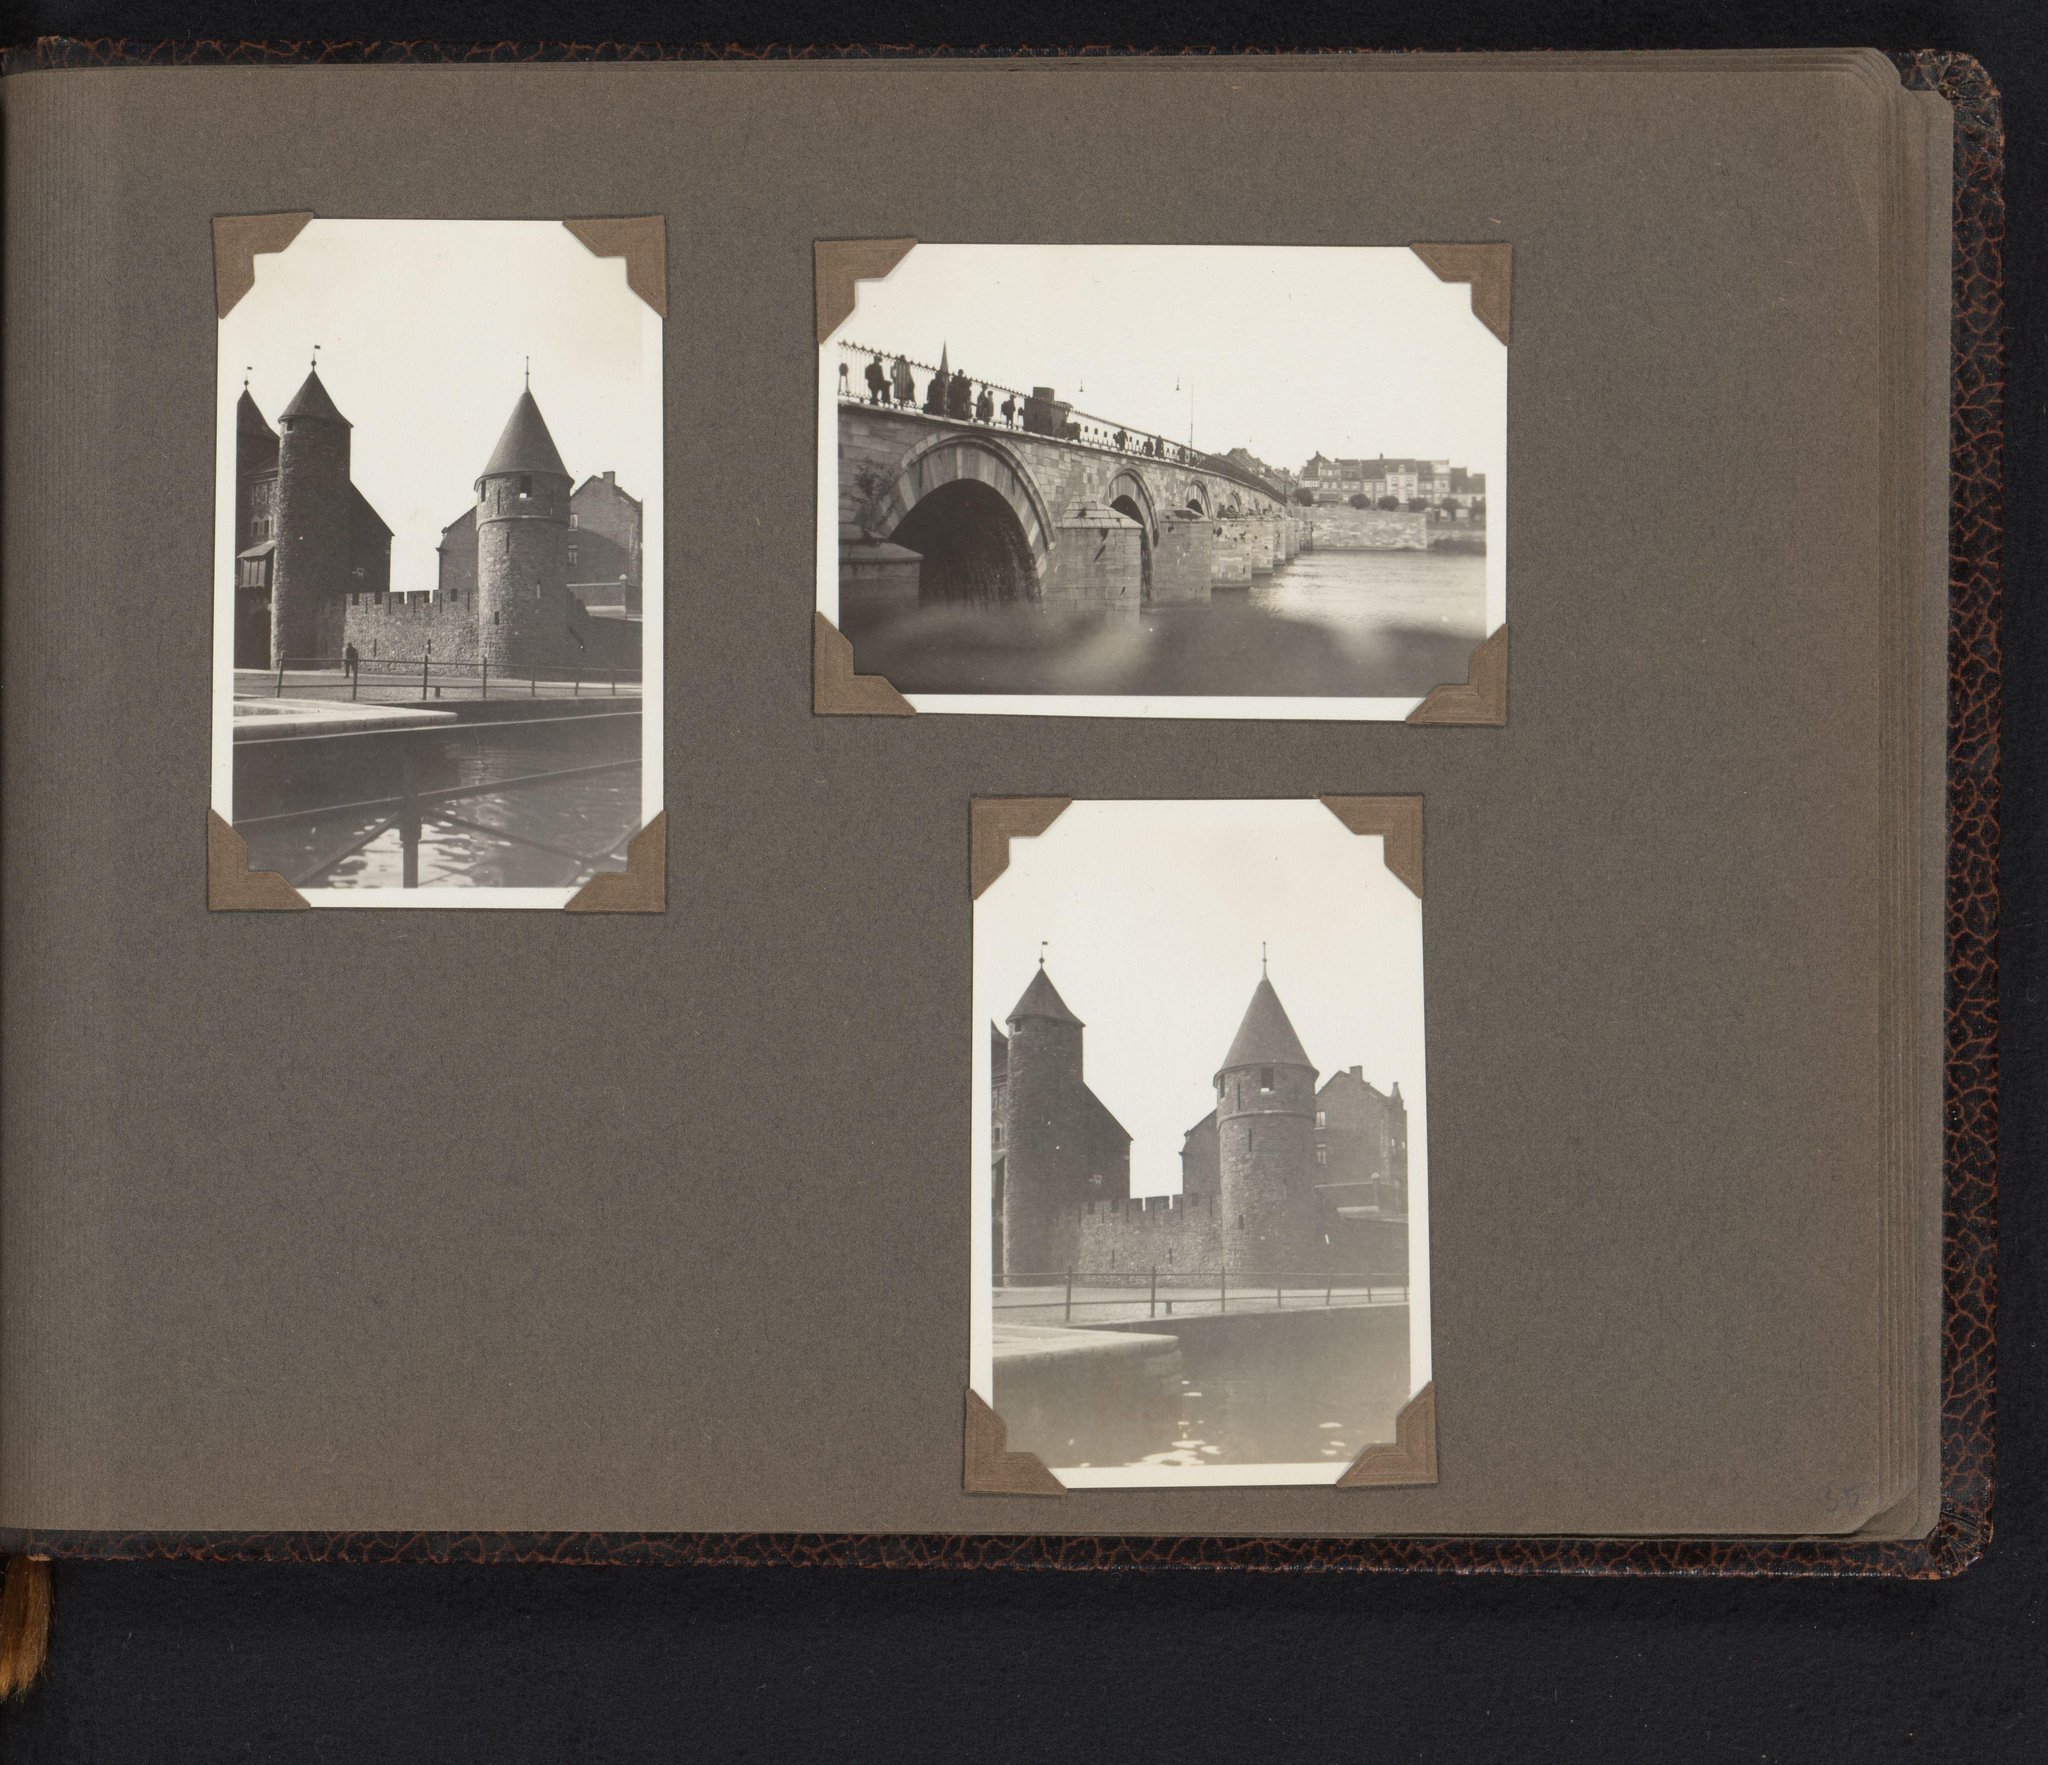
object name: photograph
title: Bezoek aan Maastricht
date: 1930-1931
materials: cardboard, paper, photographic support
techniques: gelatin silver print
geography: maastricht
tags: city-gate, landscape with bridge, viaduct or aqueduct (+ city(-scape) with figures, staffage)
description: Drie foto's van bezienswaardigheden in Maastricht, de Sint-Servaasbrug en de Helpoort. Deze pagina maakt deel uit van een album.